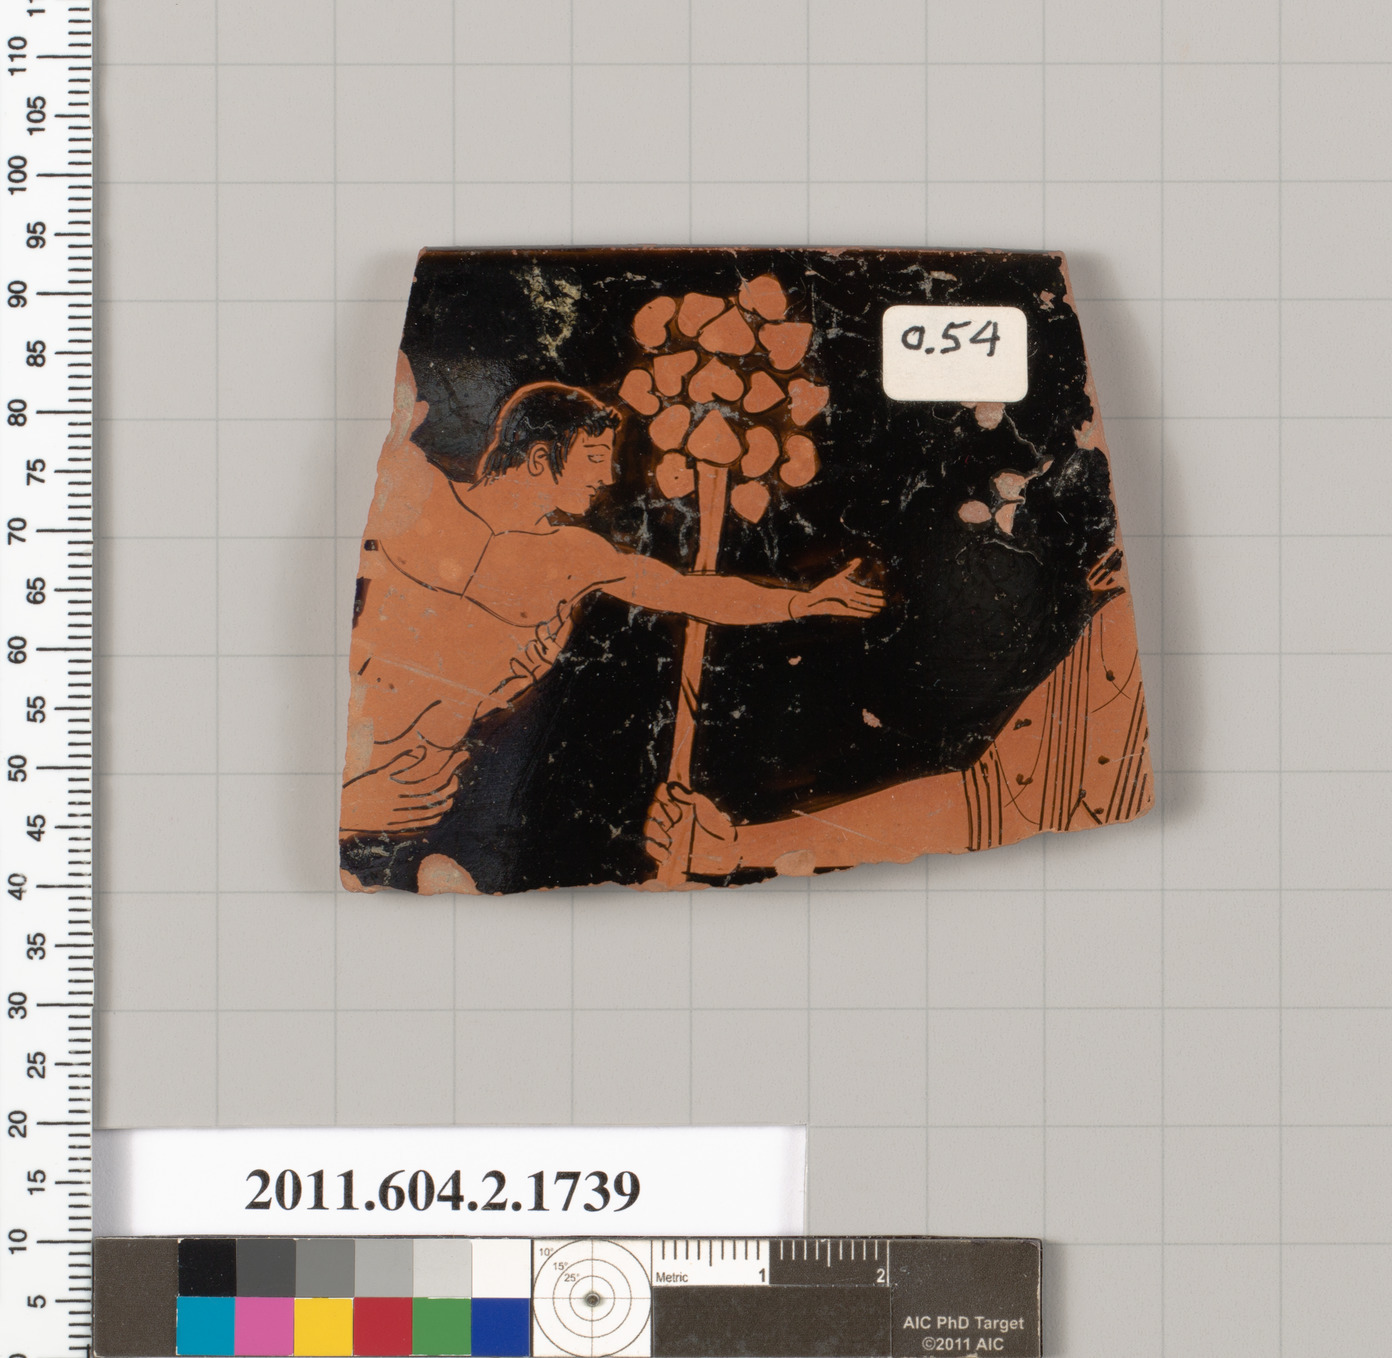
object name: skyphos fragment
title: Terracotta rim fragment of a skyphos (deep drinking cup)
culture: greek, attic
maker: lewis painter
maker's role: artist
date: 480-470 BCE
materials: terracotta